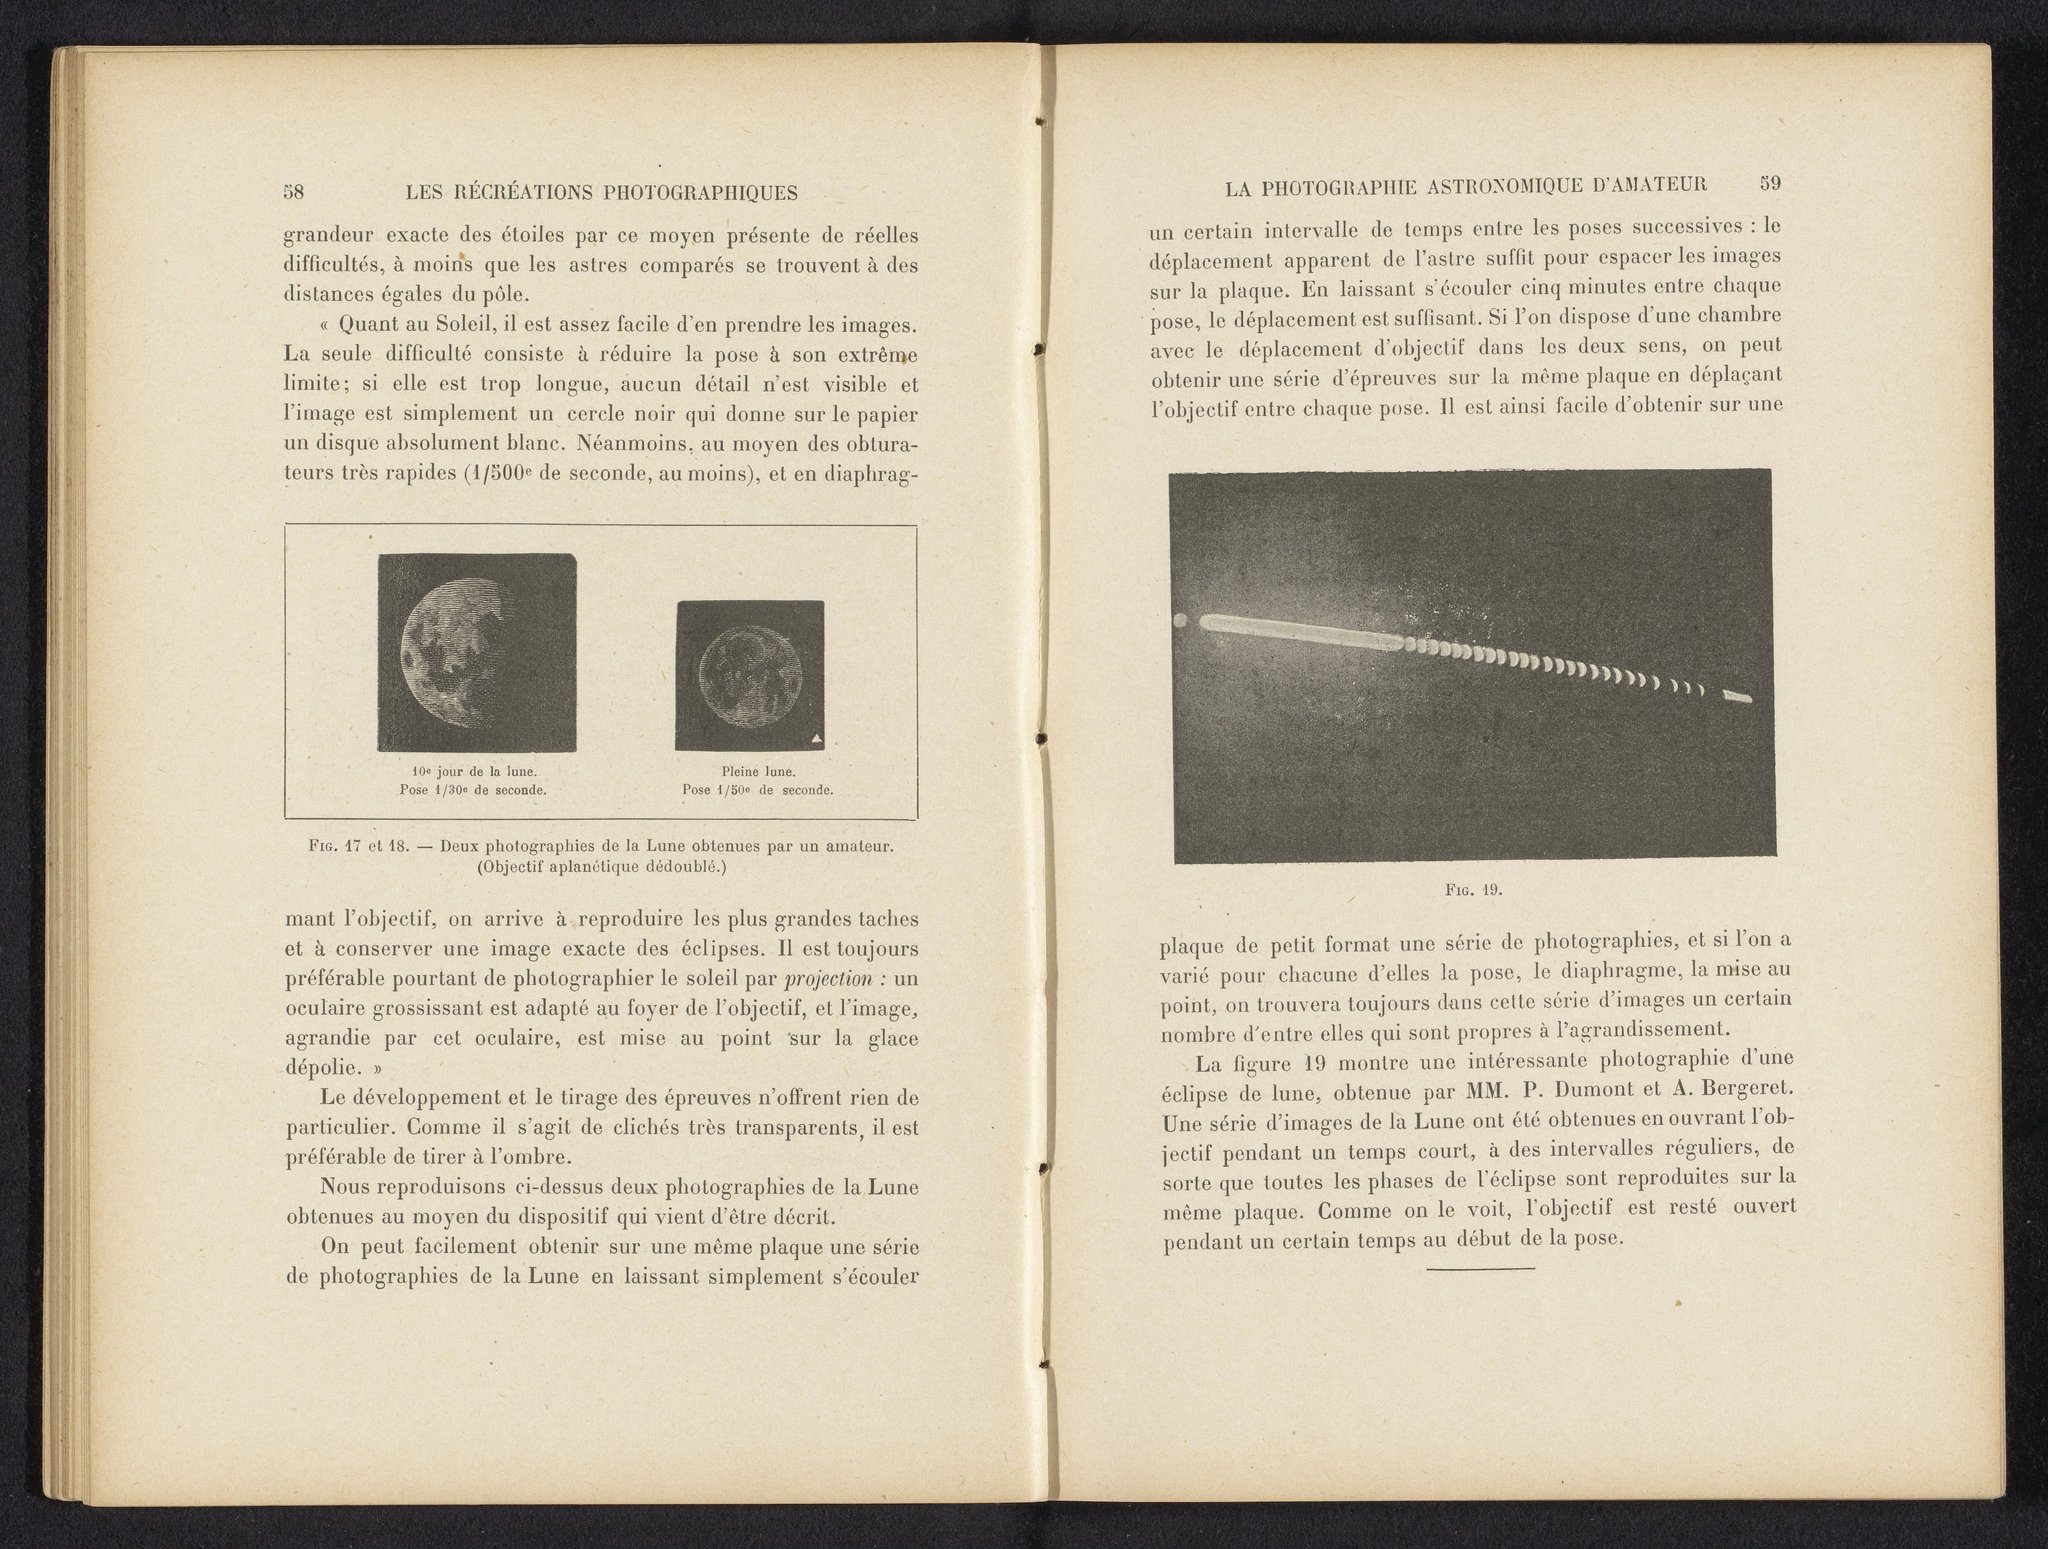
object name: photomechanical print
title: Verloop van een eclips van de maan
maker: Anonymous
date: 1883-1893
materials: paper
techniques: autotype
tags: eclipse of the moon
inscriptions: number: ‘Fig. 19.’